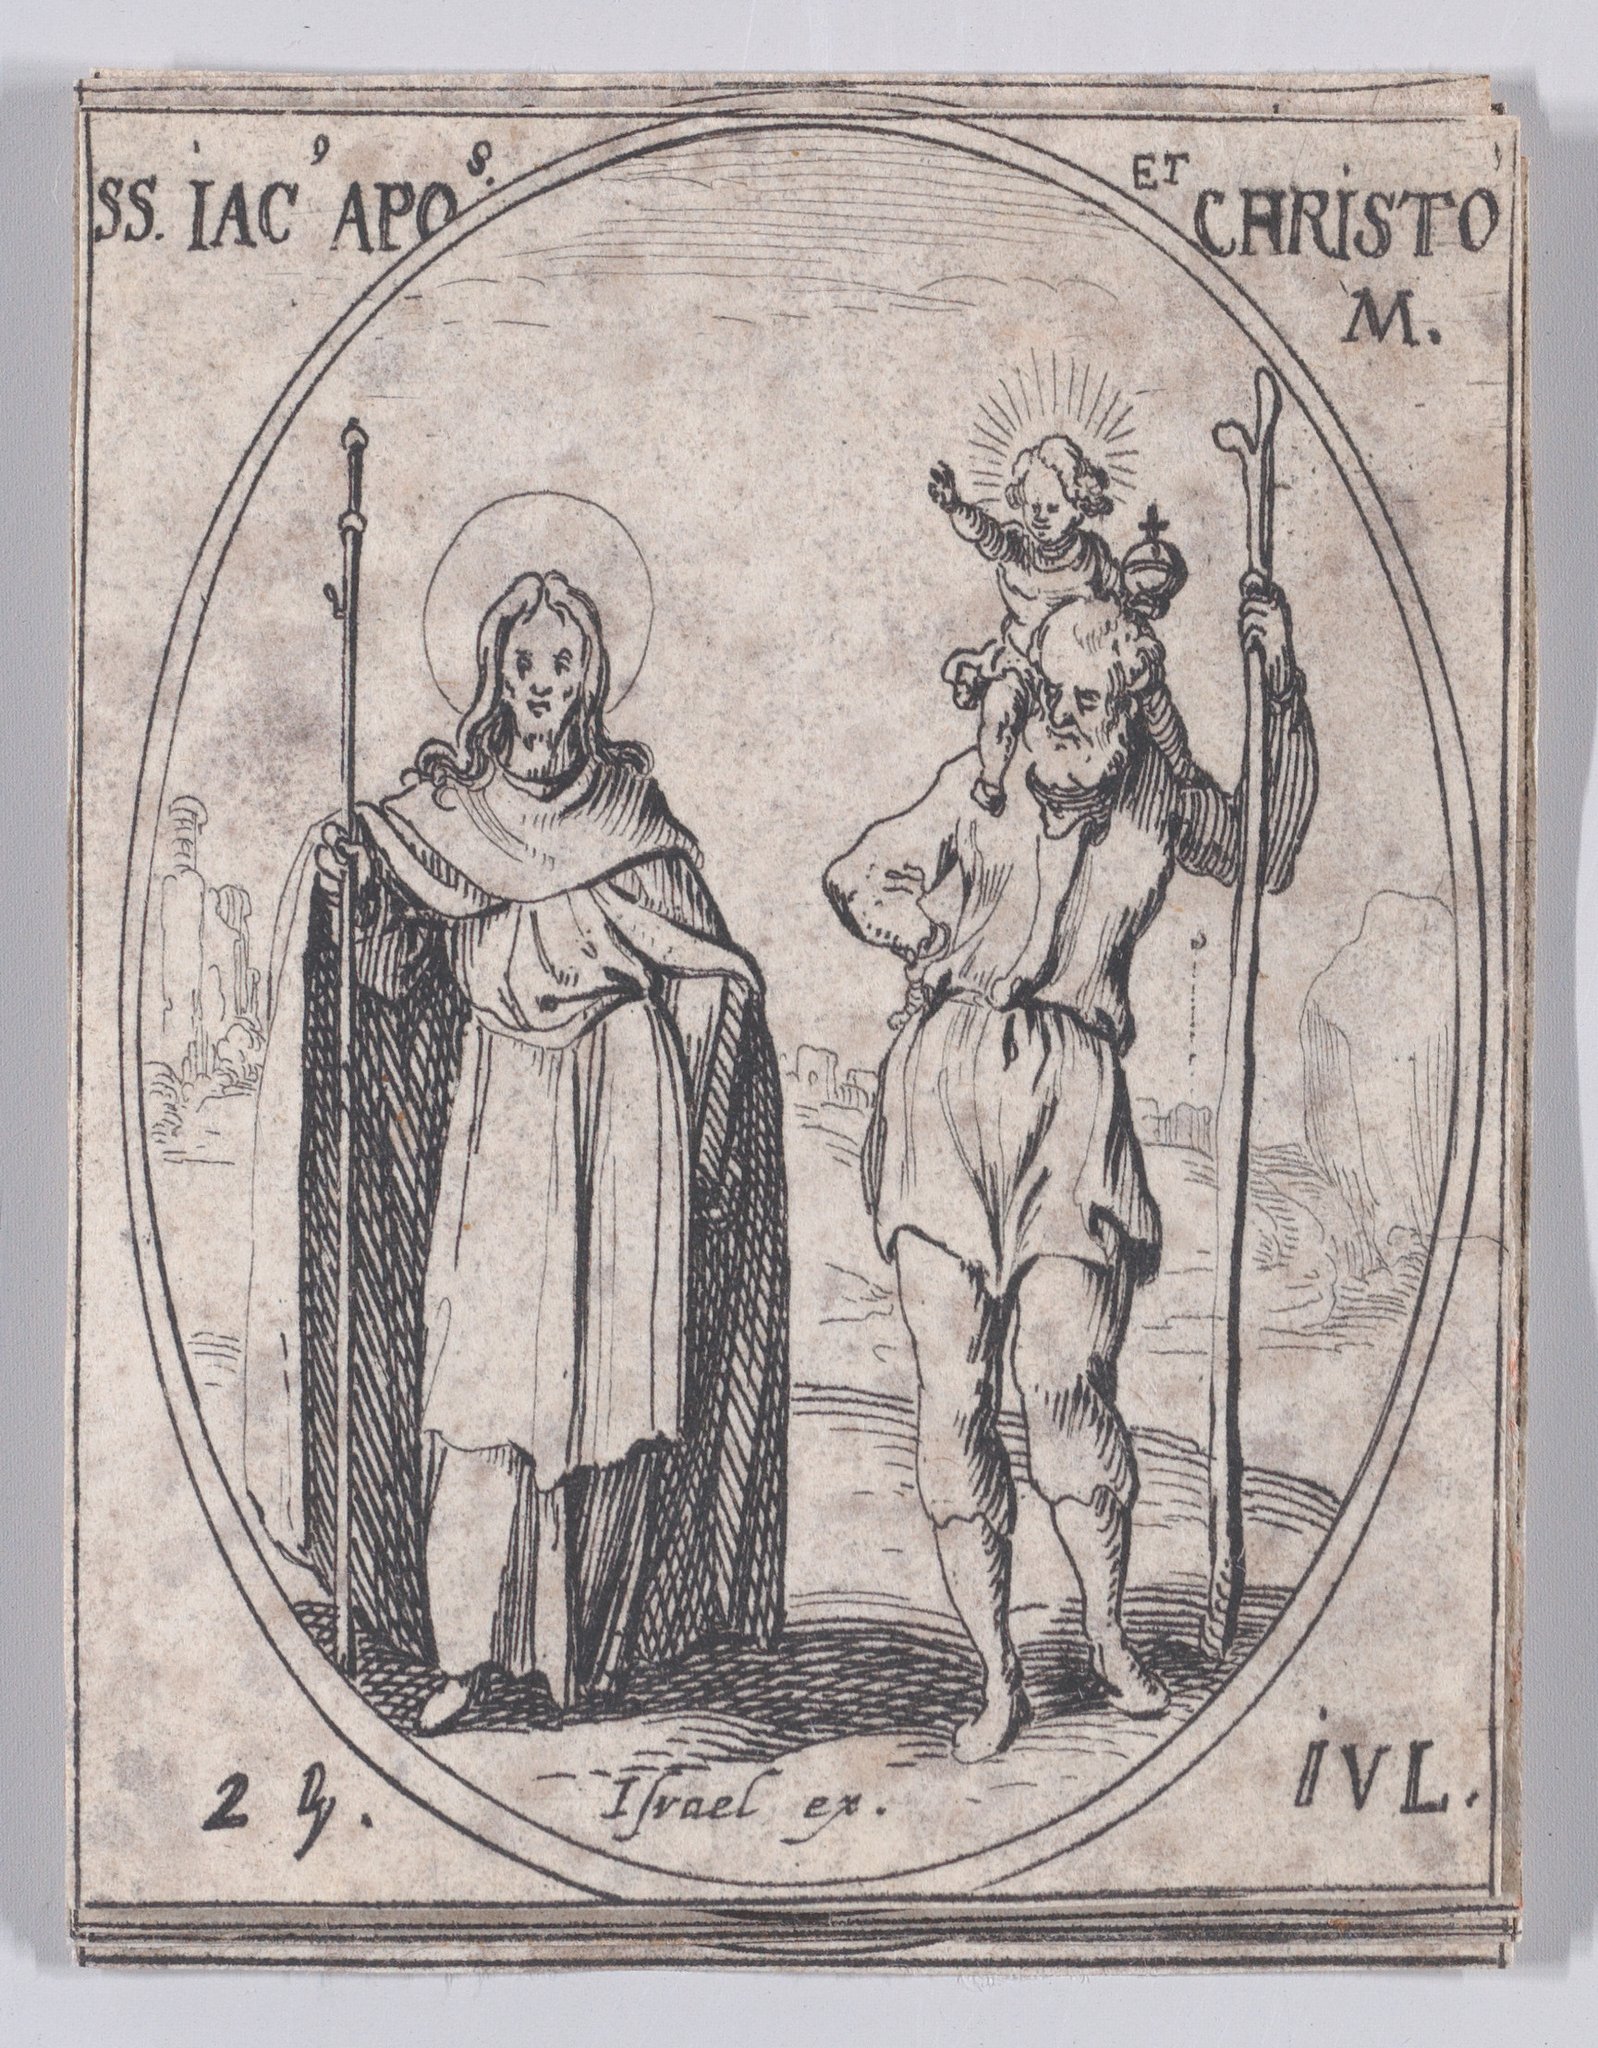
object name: print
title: S. Jacques, apôtre et S. Christope (St. James, Apostle and St. Christopher), July 25th, from "Les Images De Tous Les Saincts et Saintes de L'Année" (Images of All of the Saints and Religious Events of the Year)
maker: jacques callot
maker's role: artist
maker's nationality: french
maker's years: 1592-1635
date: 1636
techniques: etching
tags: men,saints